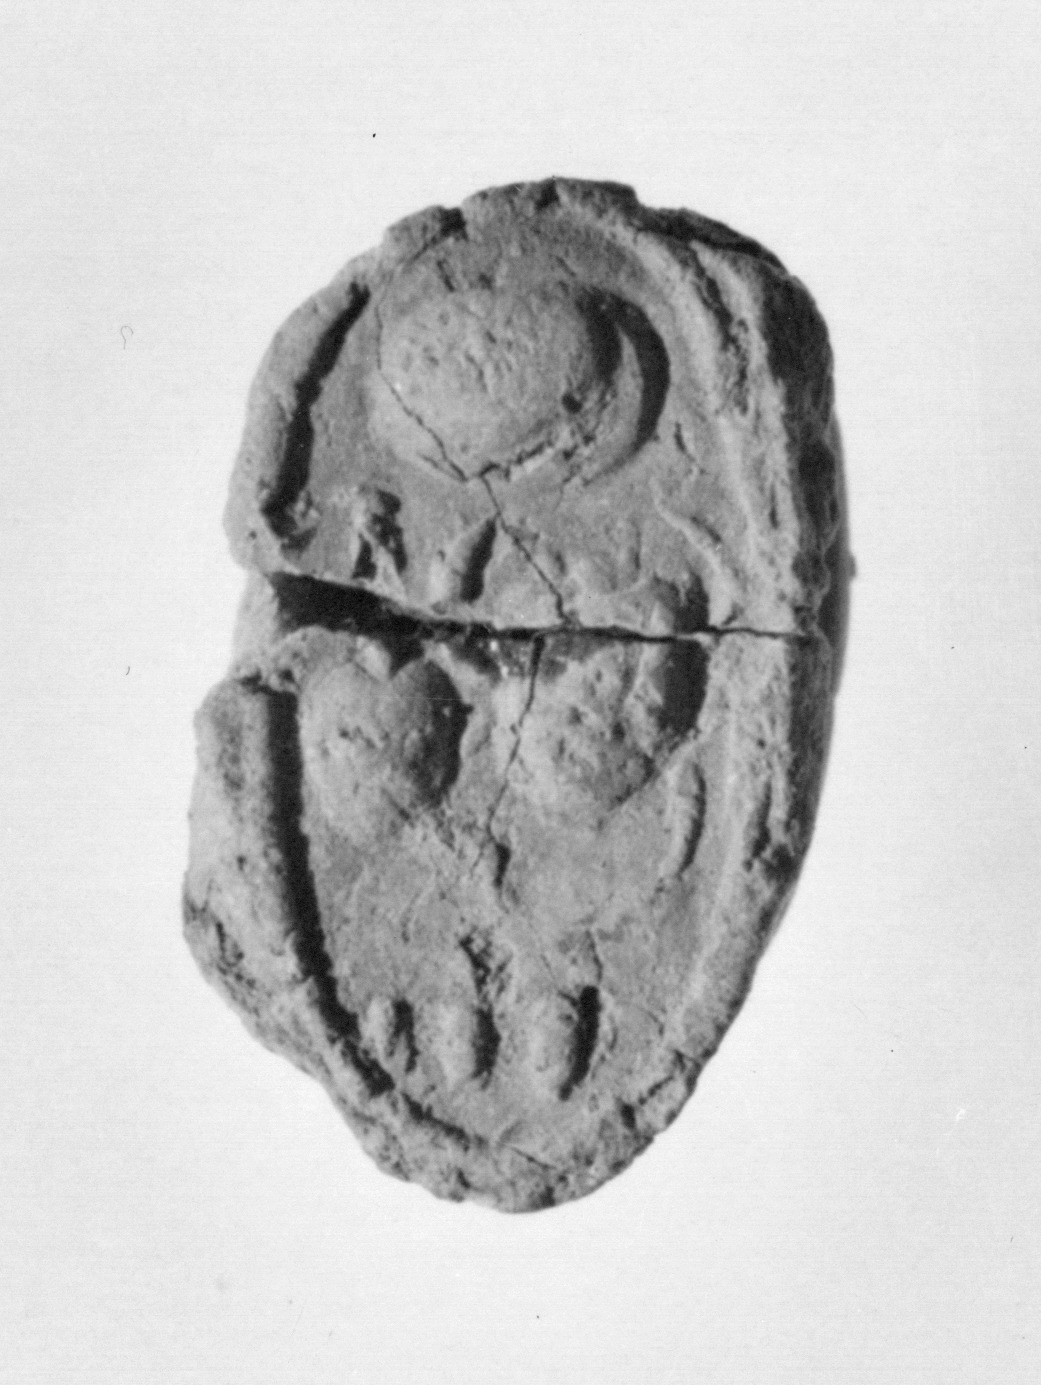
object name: sealing, amenhotep iv, akhenaten, neferkheperure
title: Document Sealing With the Throne Name of Amenhotep IV (Akhenaten)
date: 1390-1352 BCE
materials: mud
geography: egypt